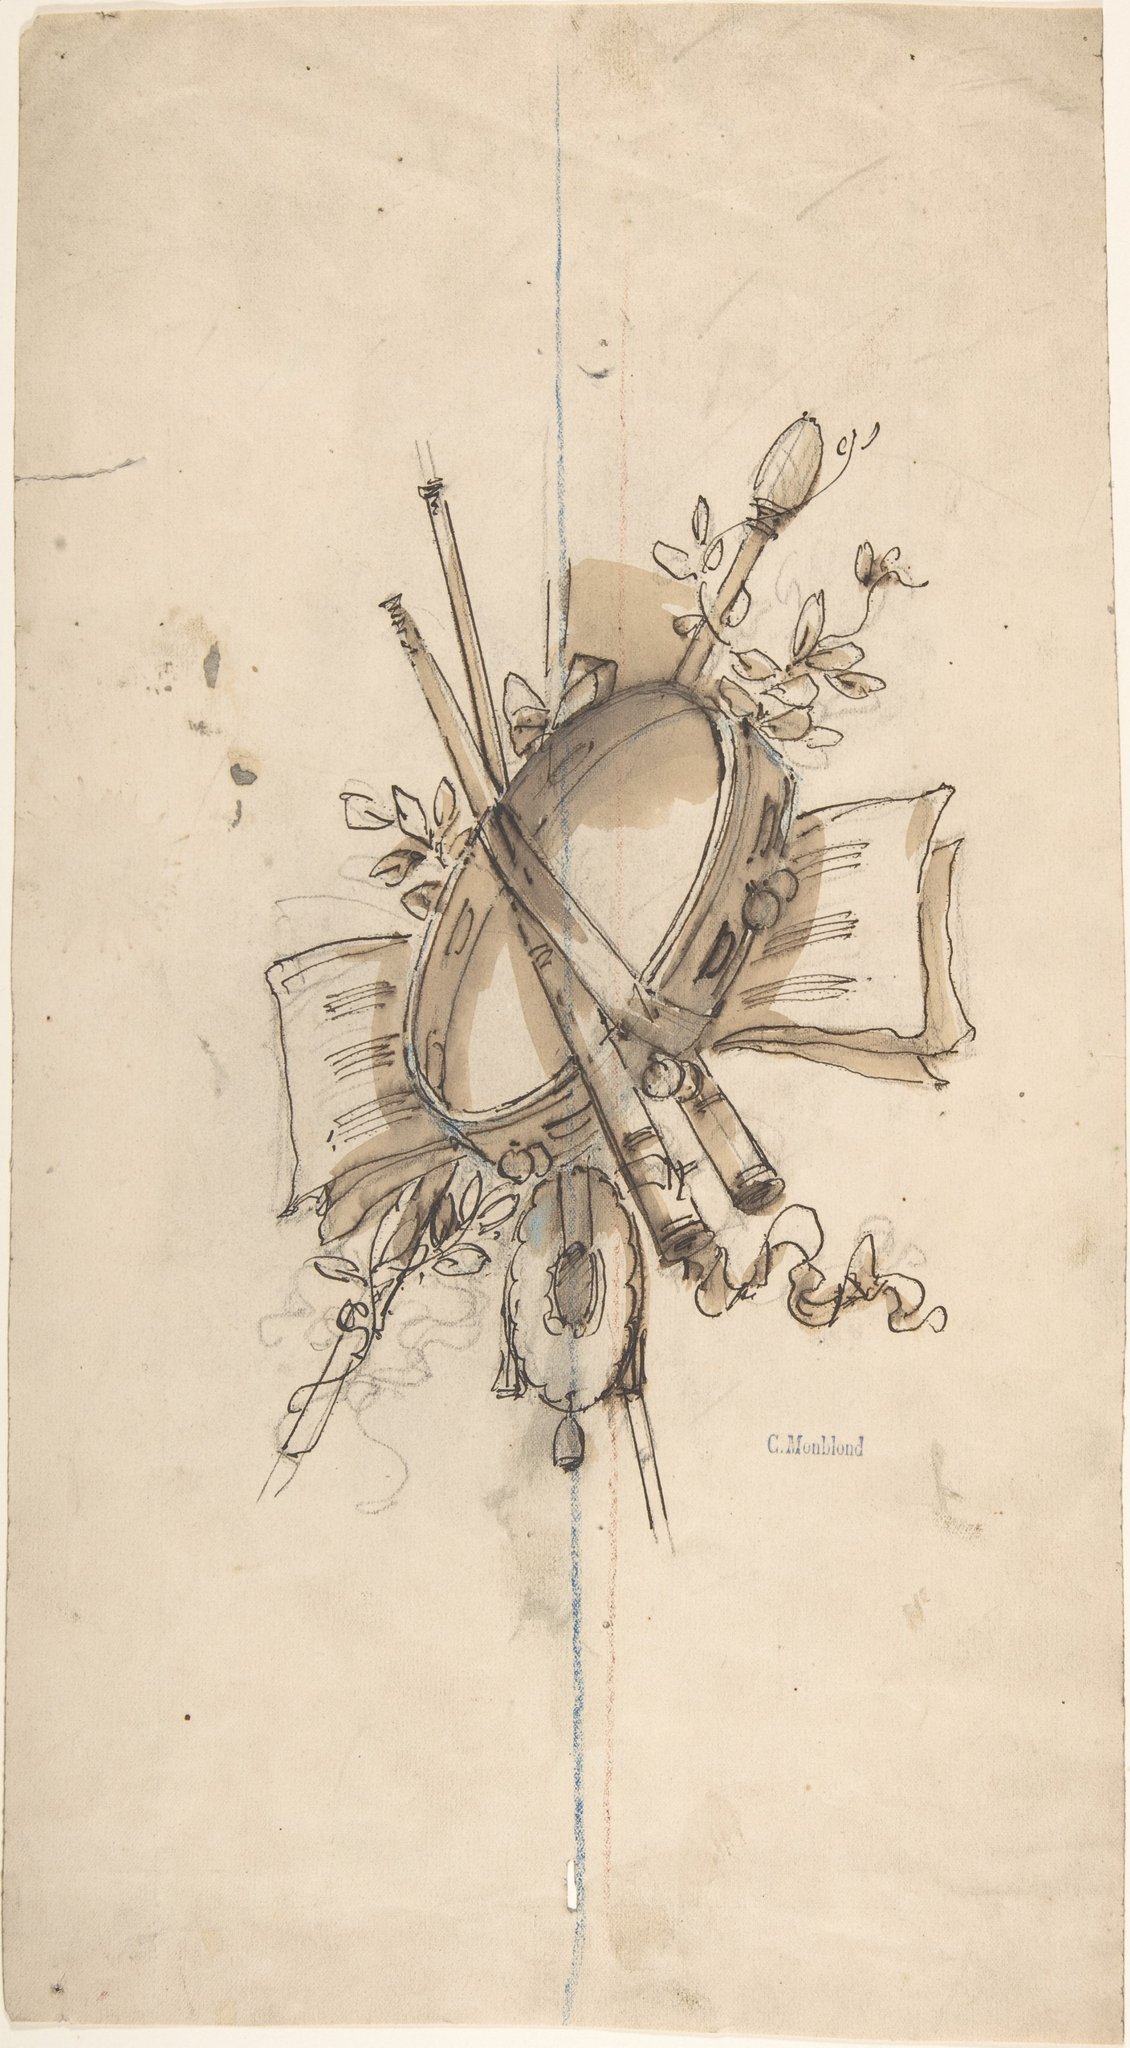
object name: drawing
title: Musical Trophy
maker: charles monblond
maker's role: artist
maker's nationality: french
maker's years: 1800-1900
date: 1801-1900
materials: graphite, ink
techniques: brush, pen, transfer, wash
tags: musical instruments,trophies